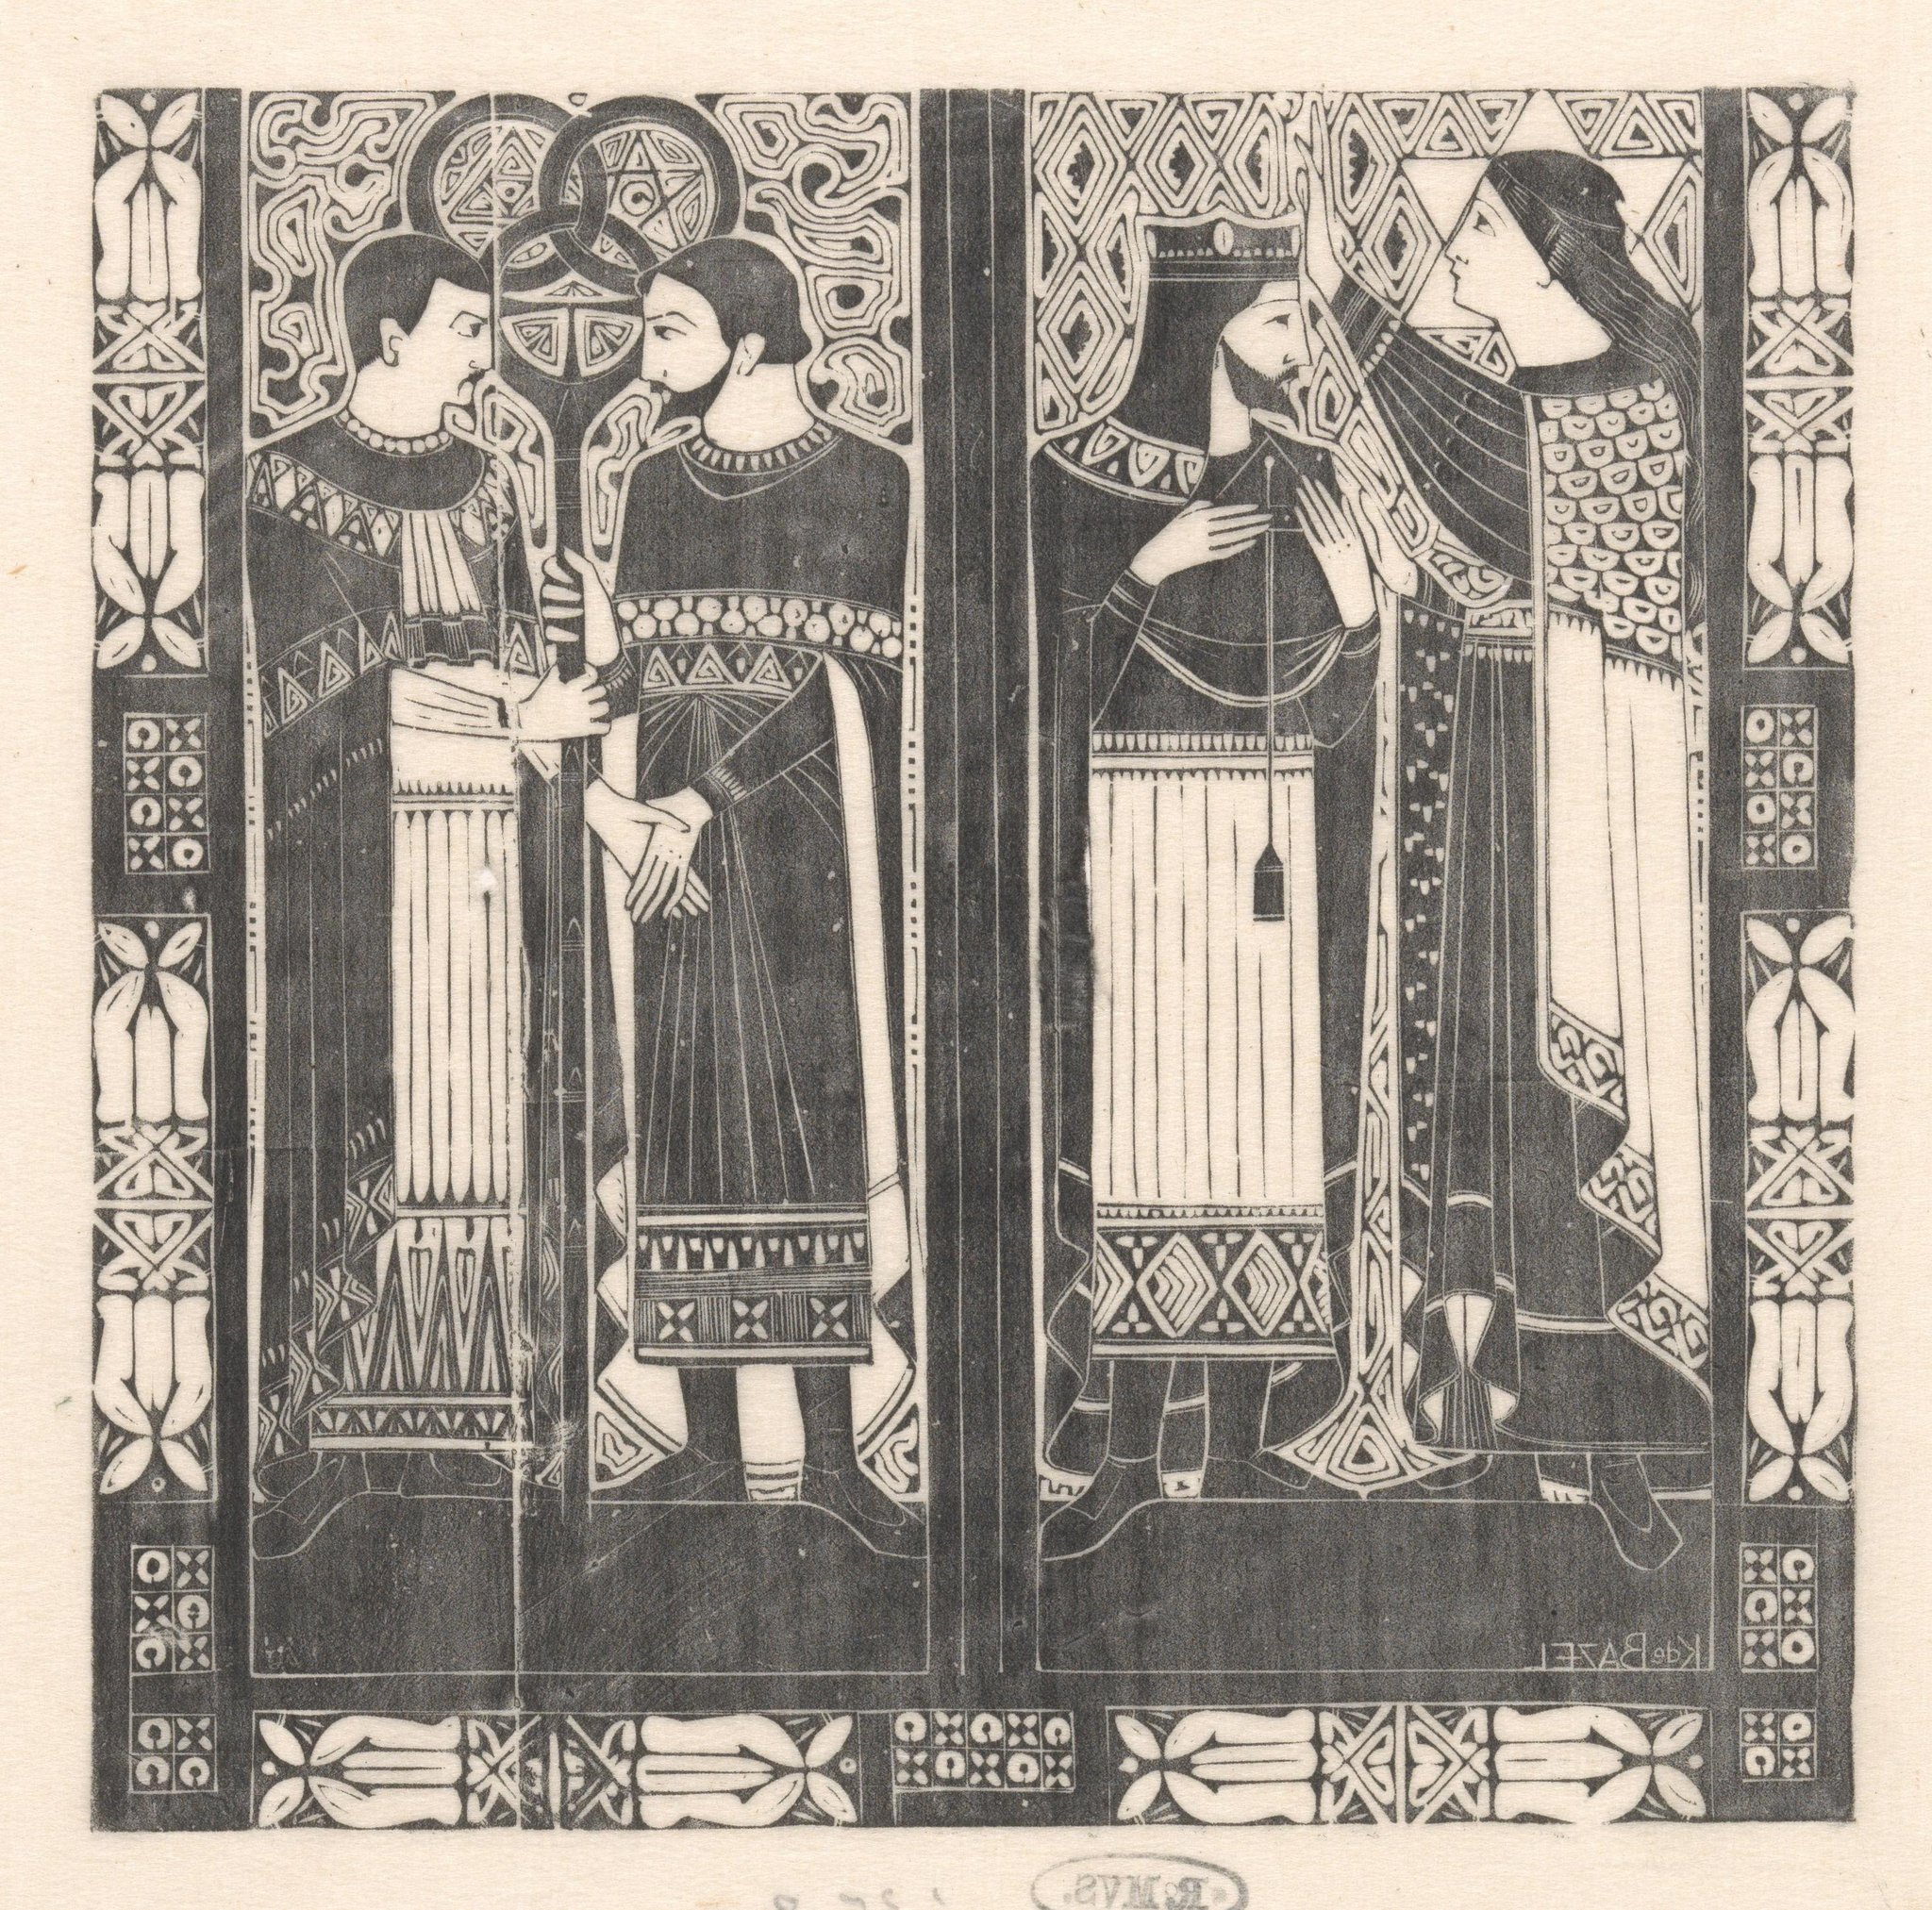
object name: print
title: Omslagillustratie voor jubileumnummer Architectura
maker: karel petrus cornelis de bazel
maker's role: draughtsman, print maker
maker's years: 1869-1923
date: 1895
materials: paper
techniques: woodcut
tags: star-shaped nimbus, pentagram ~ magic mathematical figures, the all-seeing eye, triangle with eye ~ symbol of god the father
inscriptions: collector's mark: Lugt 2228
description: Een tweeluik. Links twee mannen die samen een staf vasthouden. Aan het uiteinde van de staf een alziend oog en een pentagram. De mannen geven elkaar een hand. Rechts een vrouw met een davidster als aureool. Ze houdt haar handpalm bij het voorhoofd van een man die een driehoekig object met slinger vasthoudt.